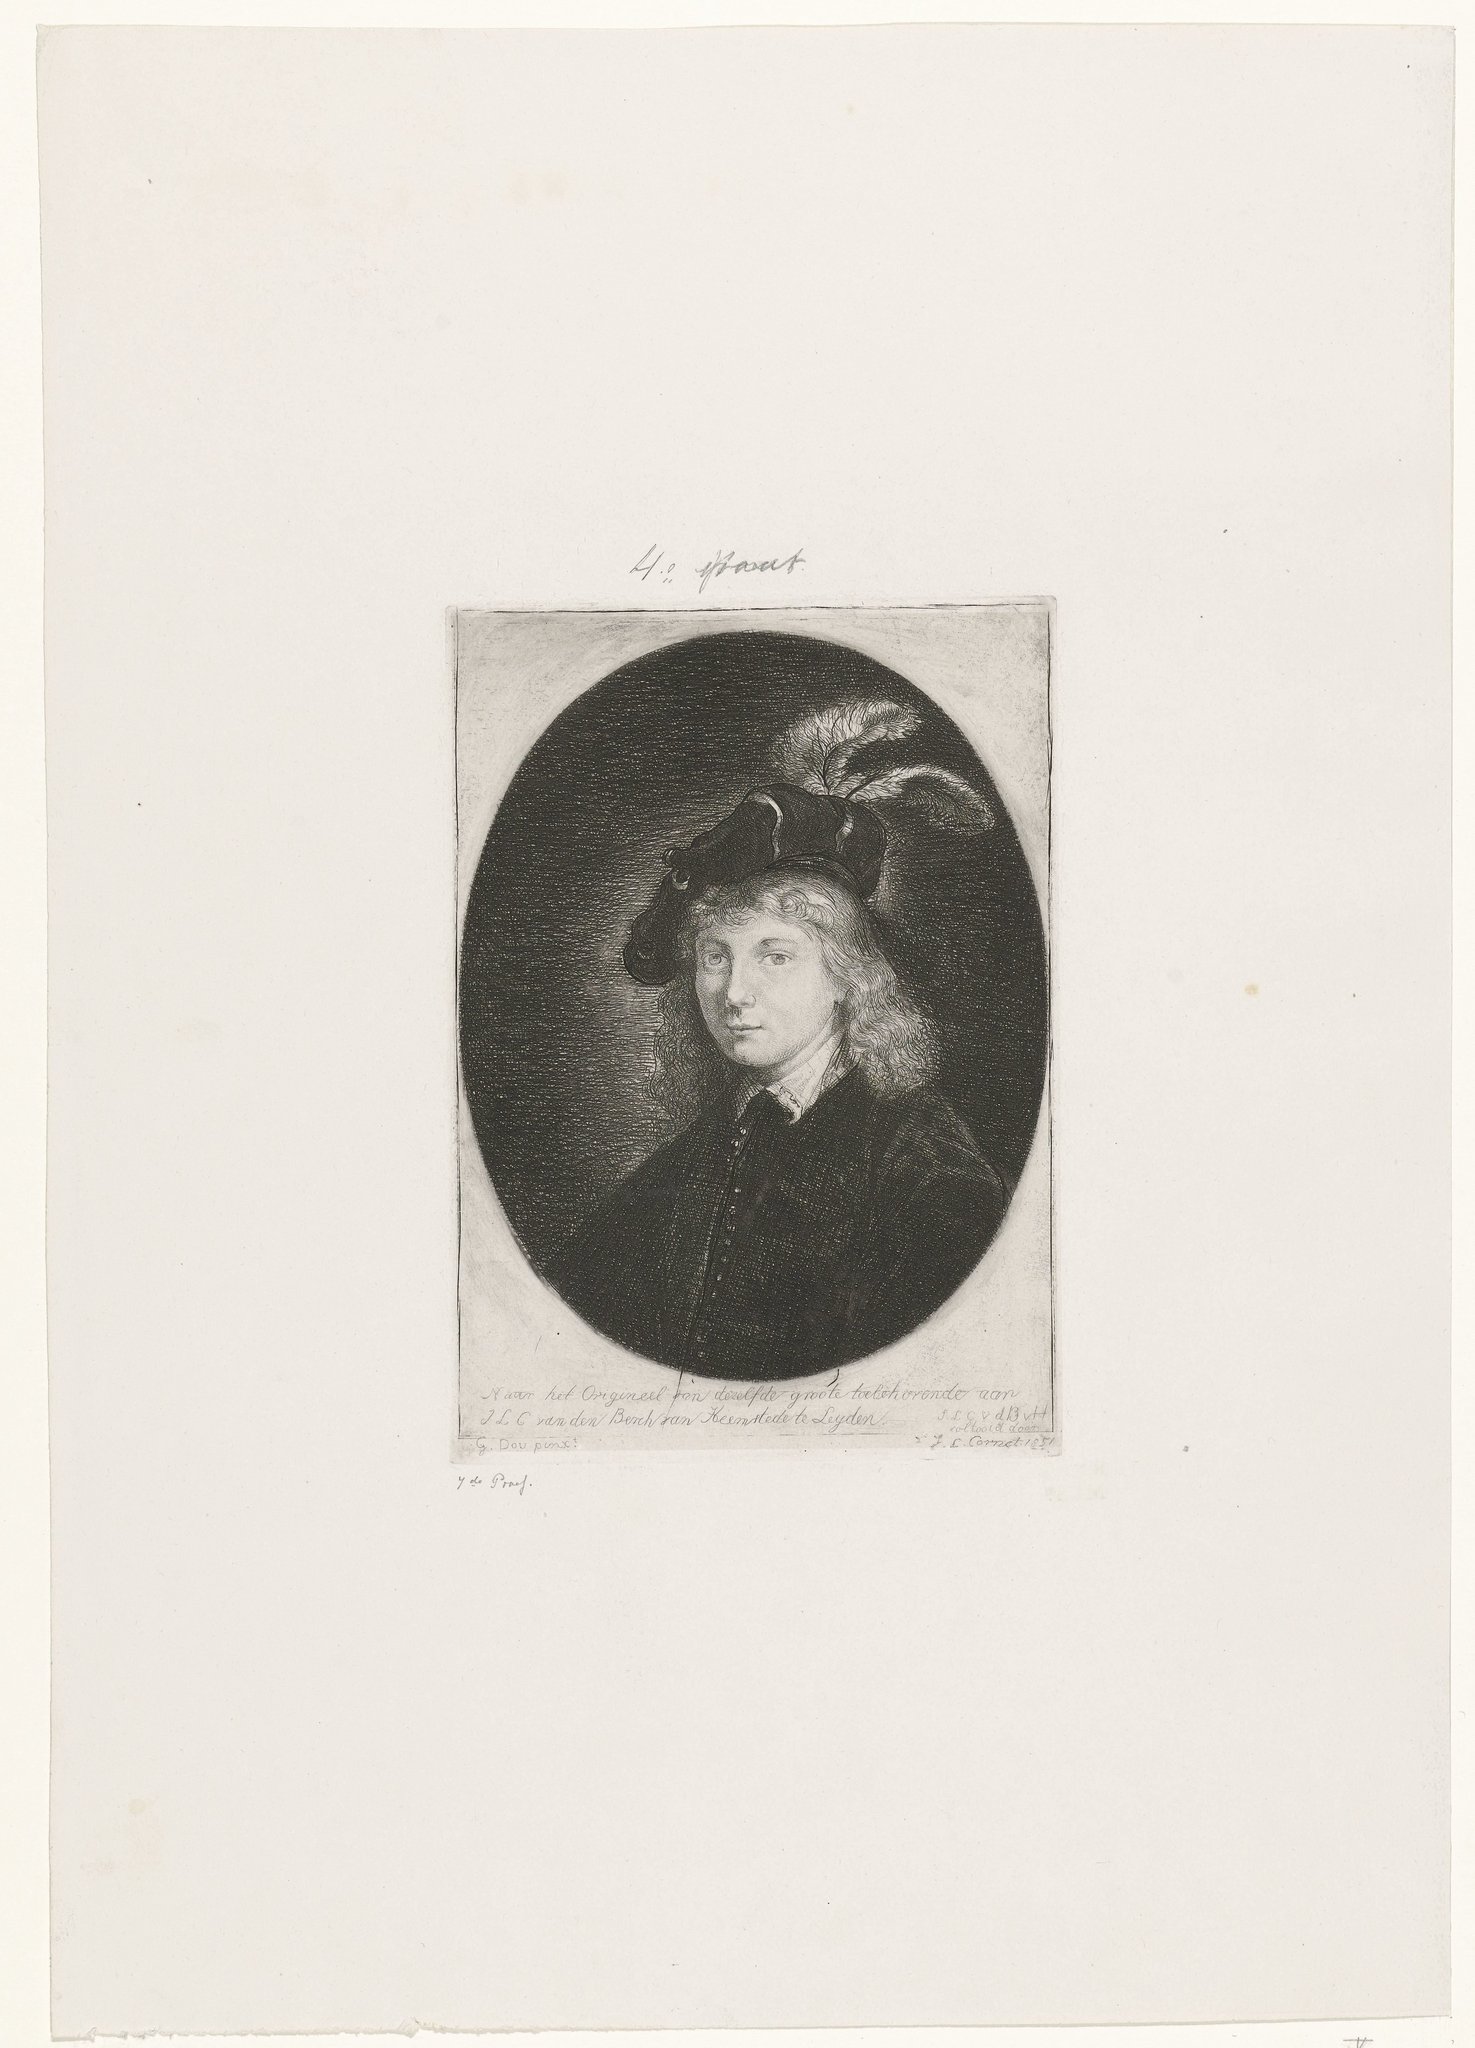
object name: print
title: Portret van Gerard Dou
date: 1851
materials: paper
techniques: etching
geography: leiden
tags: draughtsman, gerard dou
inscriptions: caption: ‘Naar het orgineel van dezelfde groote toebehorende aan J.L.C. van den Berch van Heemstede te Leyden’, inscription: ‘Afdruk van de plaat, door V.D.B. (Van den Berch). Van toen af door mij, J.L.C., besterkt en gebragh tot de 4de proef de actuaele staat der plaat ook en tot schilderijtje Dou’, caption: ‘4ste proef’, collector's mark: Lugt 2166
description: Portret van de schilder Gerard Dou in ovale lijst. Dou draagt een hoed met een pluim. Buste naar links.